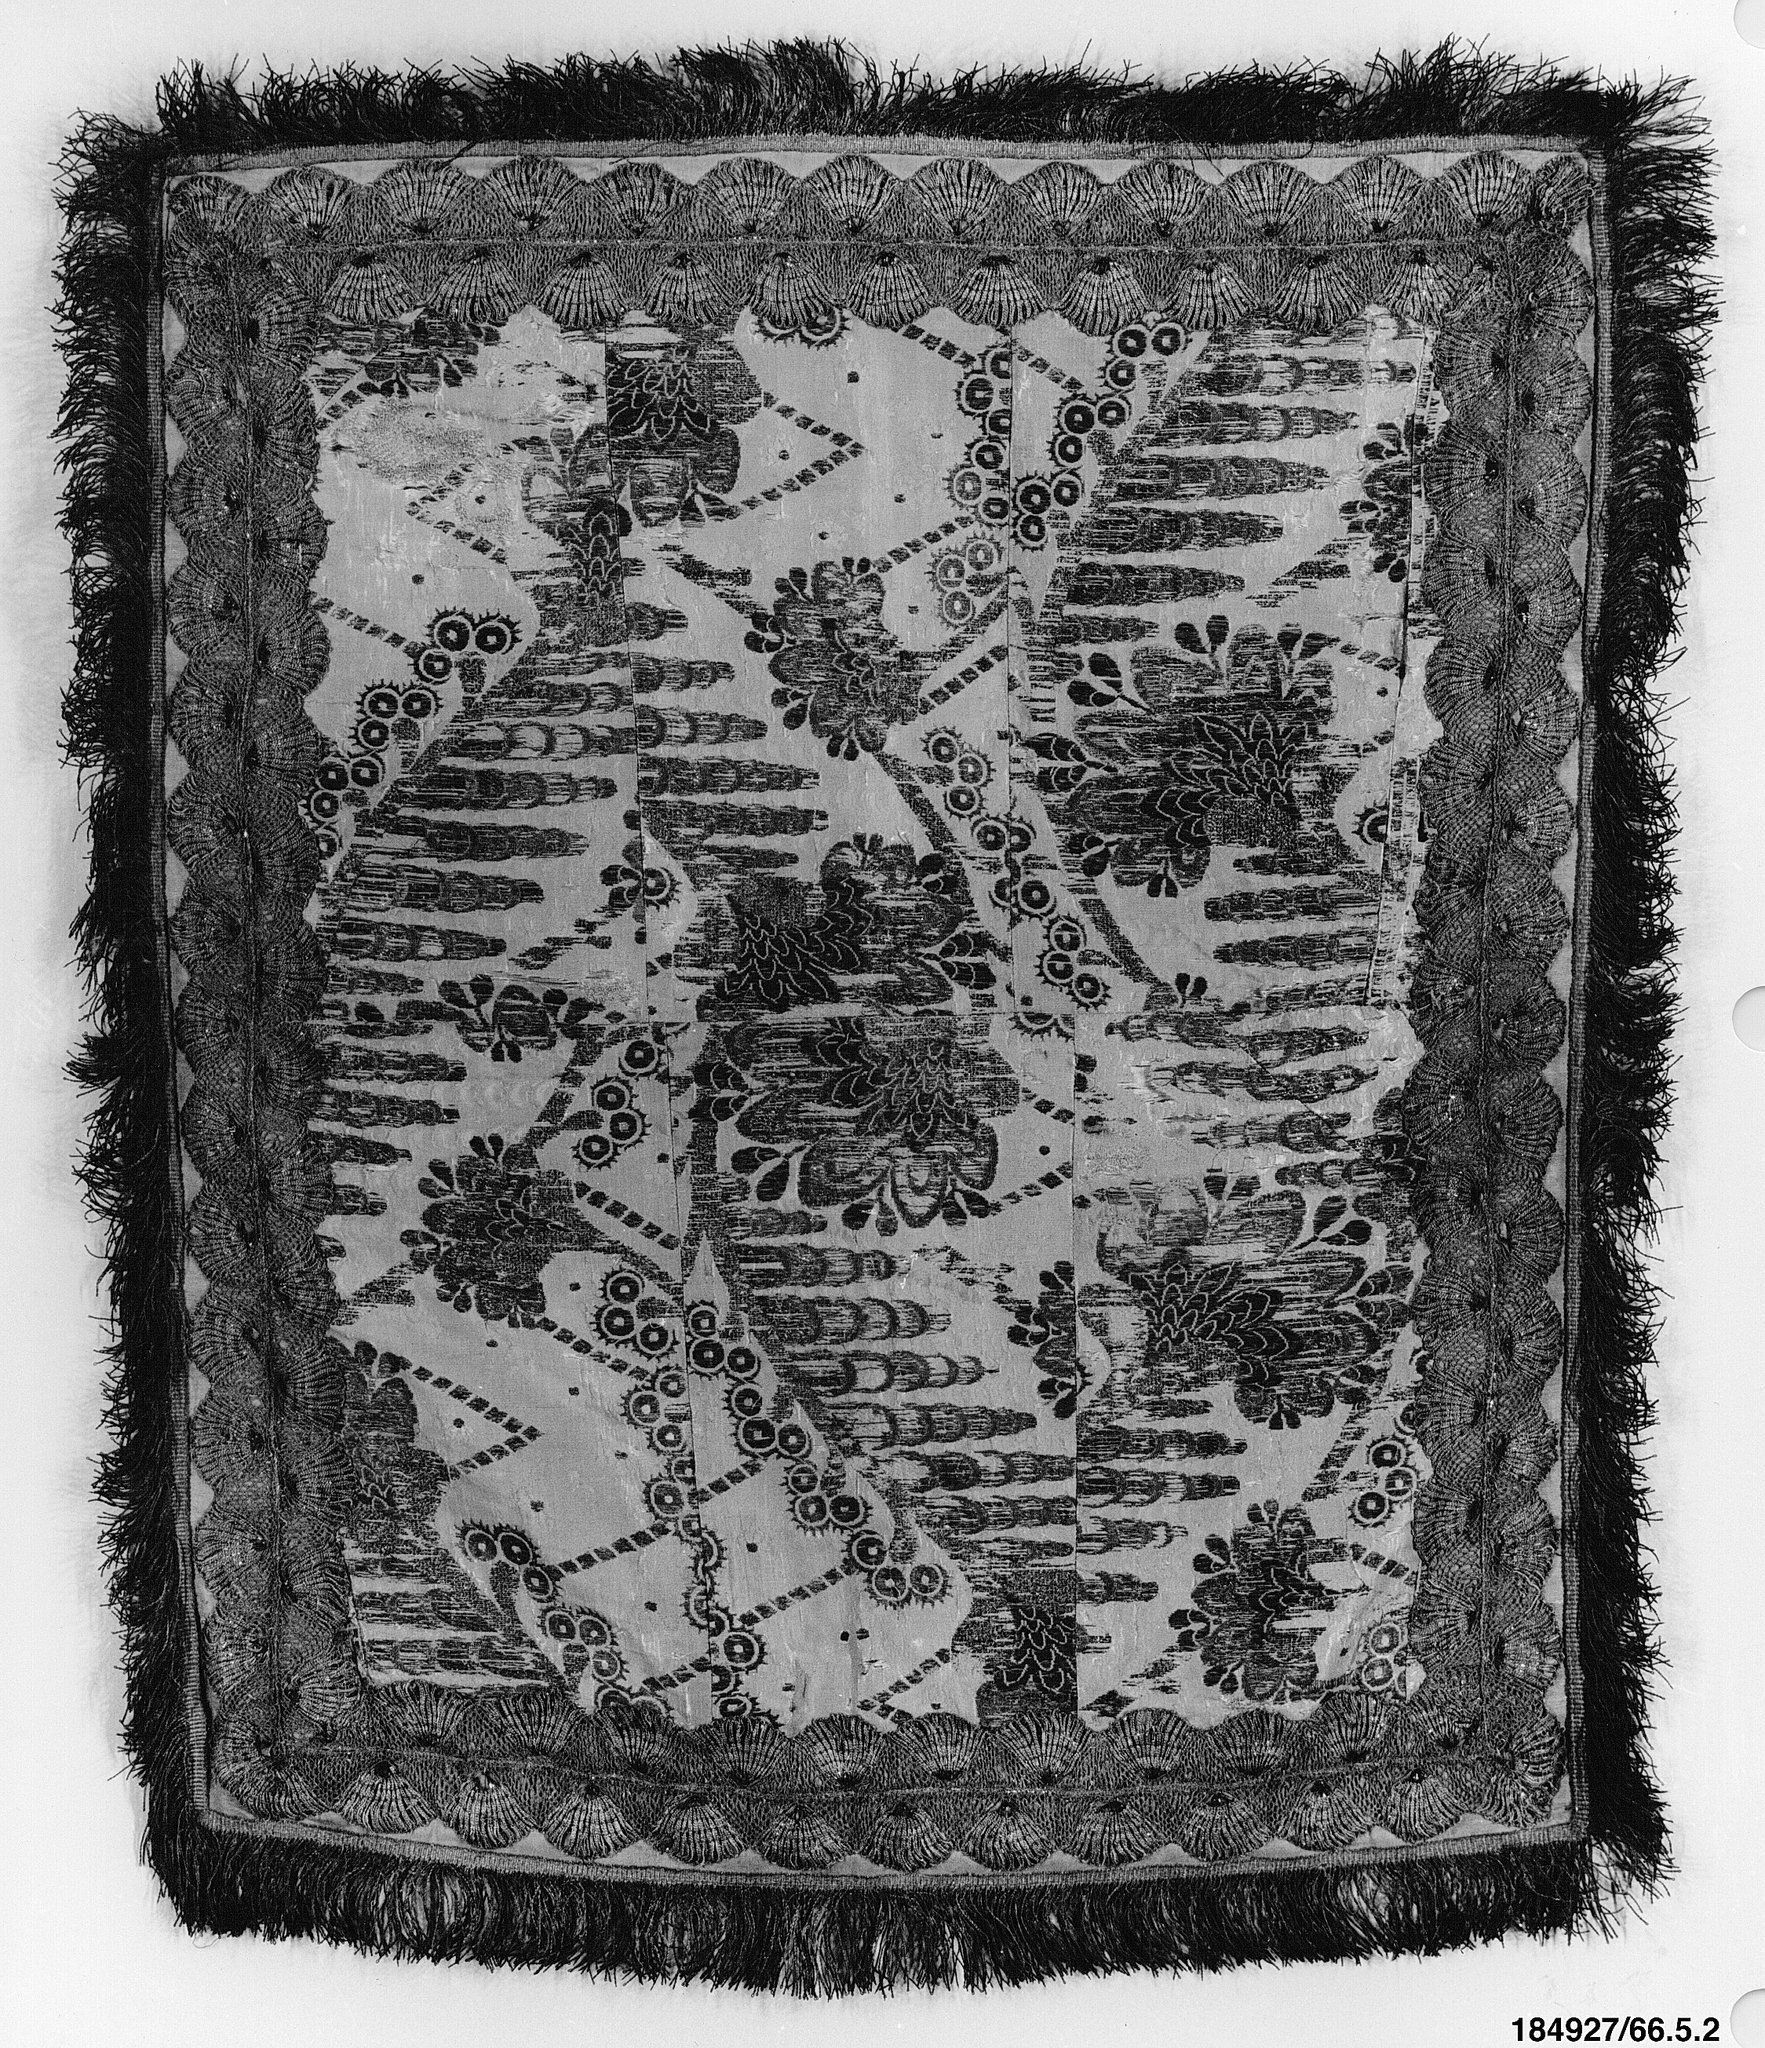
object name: panel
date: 1601-1700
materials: metal thread, silk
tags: flowers